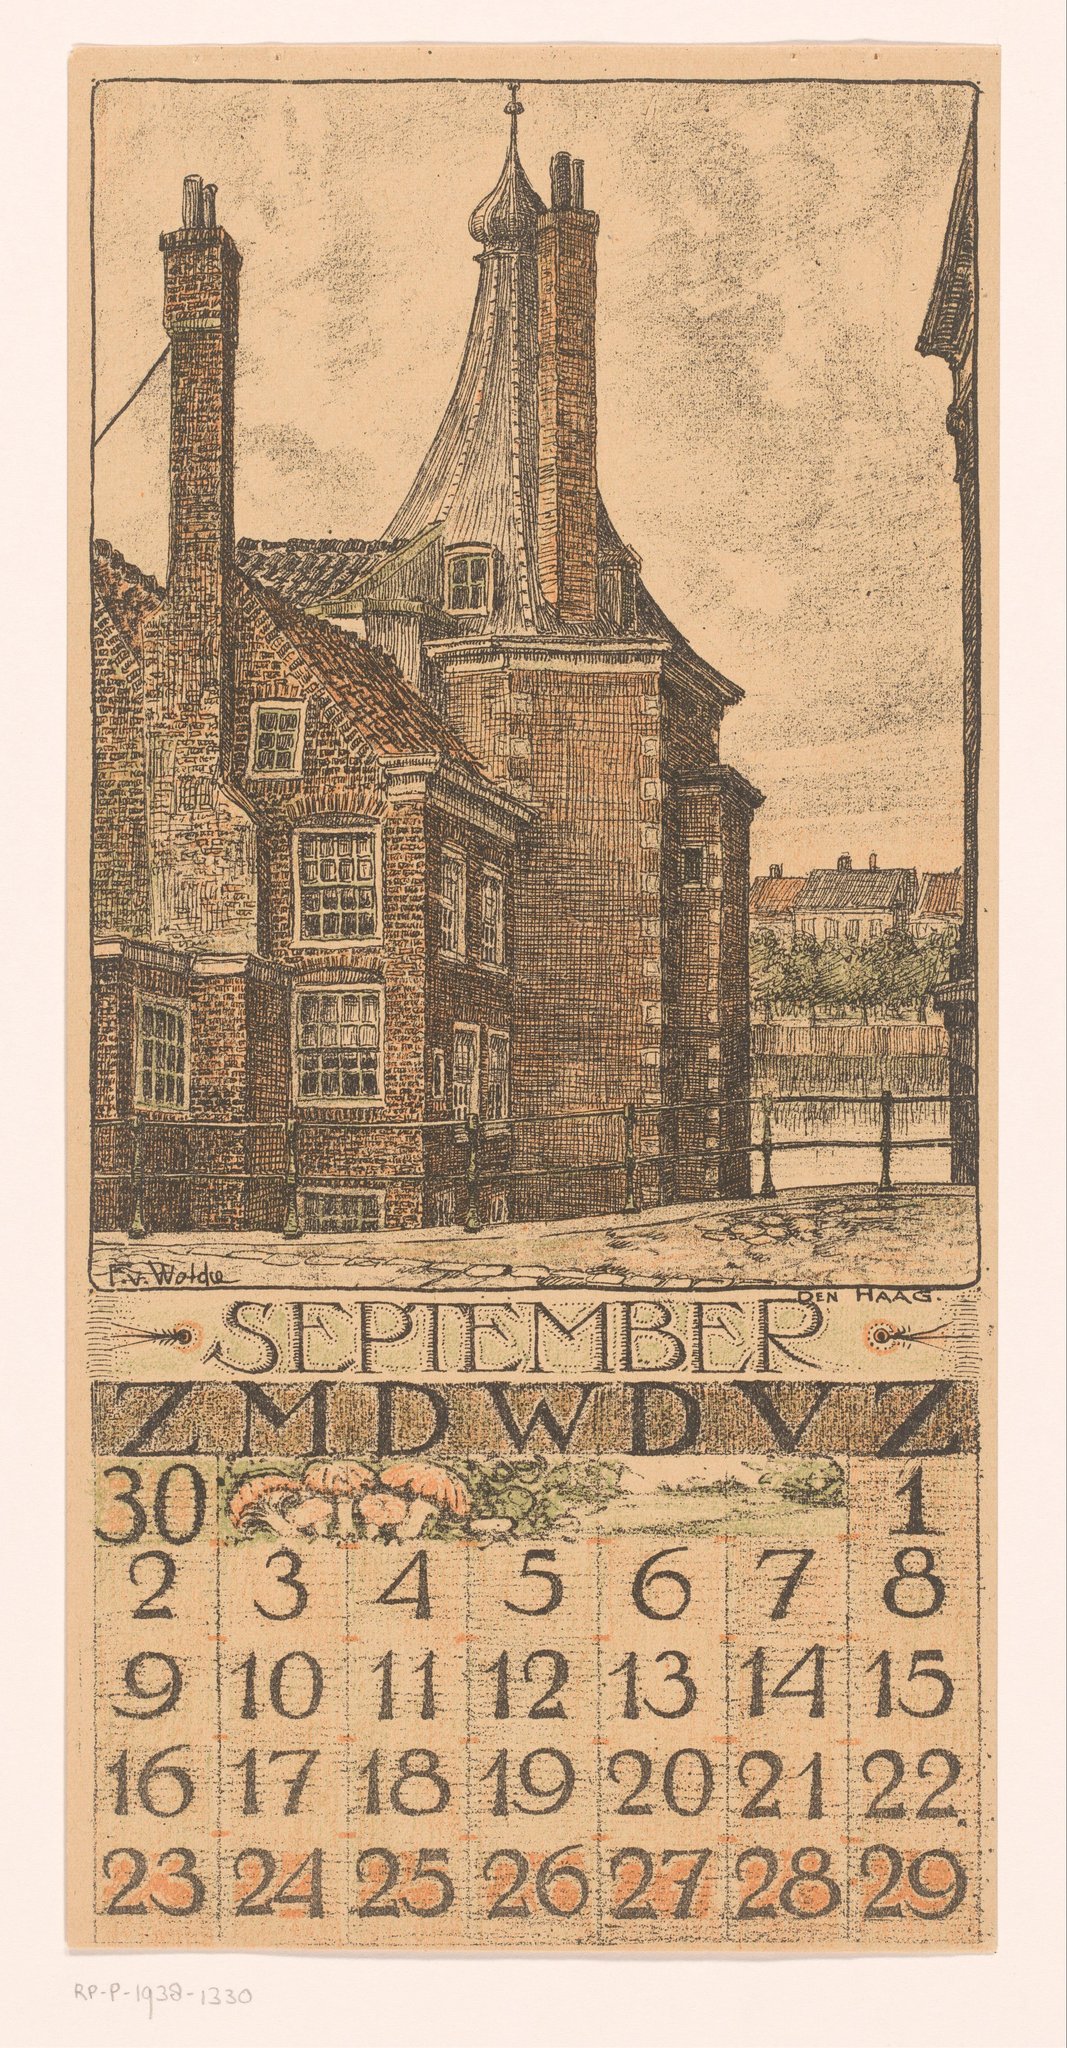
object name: calendar leaf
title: Kalenderblad september met stadsgezicht in Den Haag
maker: ferdinand van wolde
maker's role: print maker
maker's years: 1891-1945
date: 1923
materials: paper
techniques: lithograph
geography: netherlands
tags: popular representation ~ government, street, september ~ other concepts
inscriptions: collector's mark: Lugt 2228, collector's mark: Lugt 2760